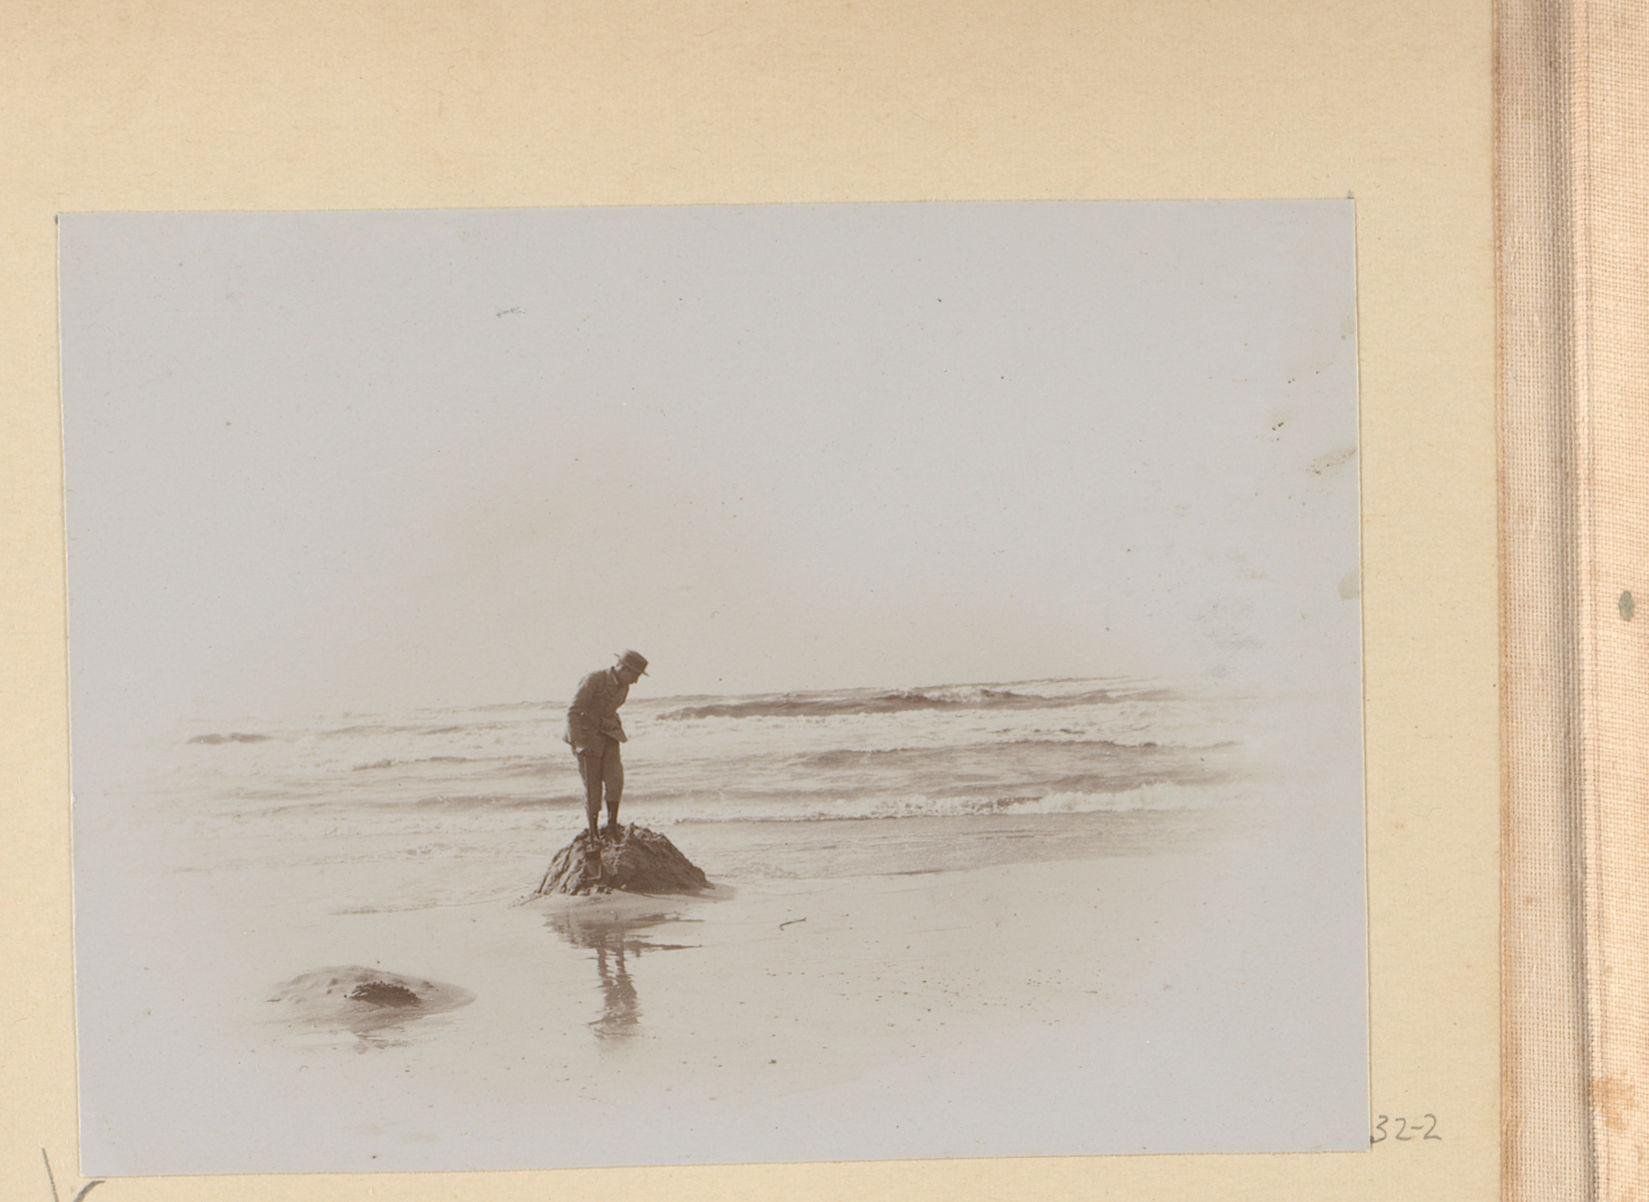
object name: photograph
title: Scheveningen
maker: hendrik herman van den berg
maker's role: amateurfotograaf, jurist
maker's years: 1875-1944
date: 1890-1894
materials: paper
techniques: collodion silver print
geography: scheveningen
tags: beach (as place of recreation), historical persons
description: Foto 2 op albumblad 32 uit album "Amsterdam 1890-1894".